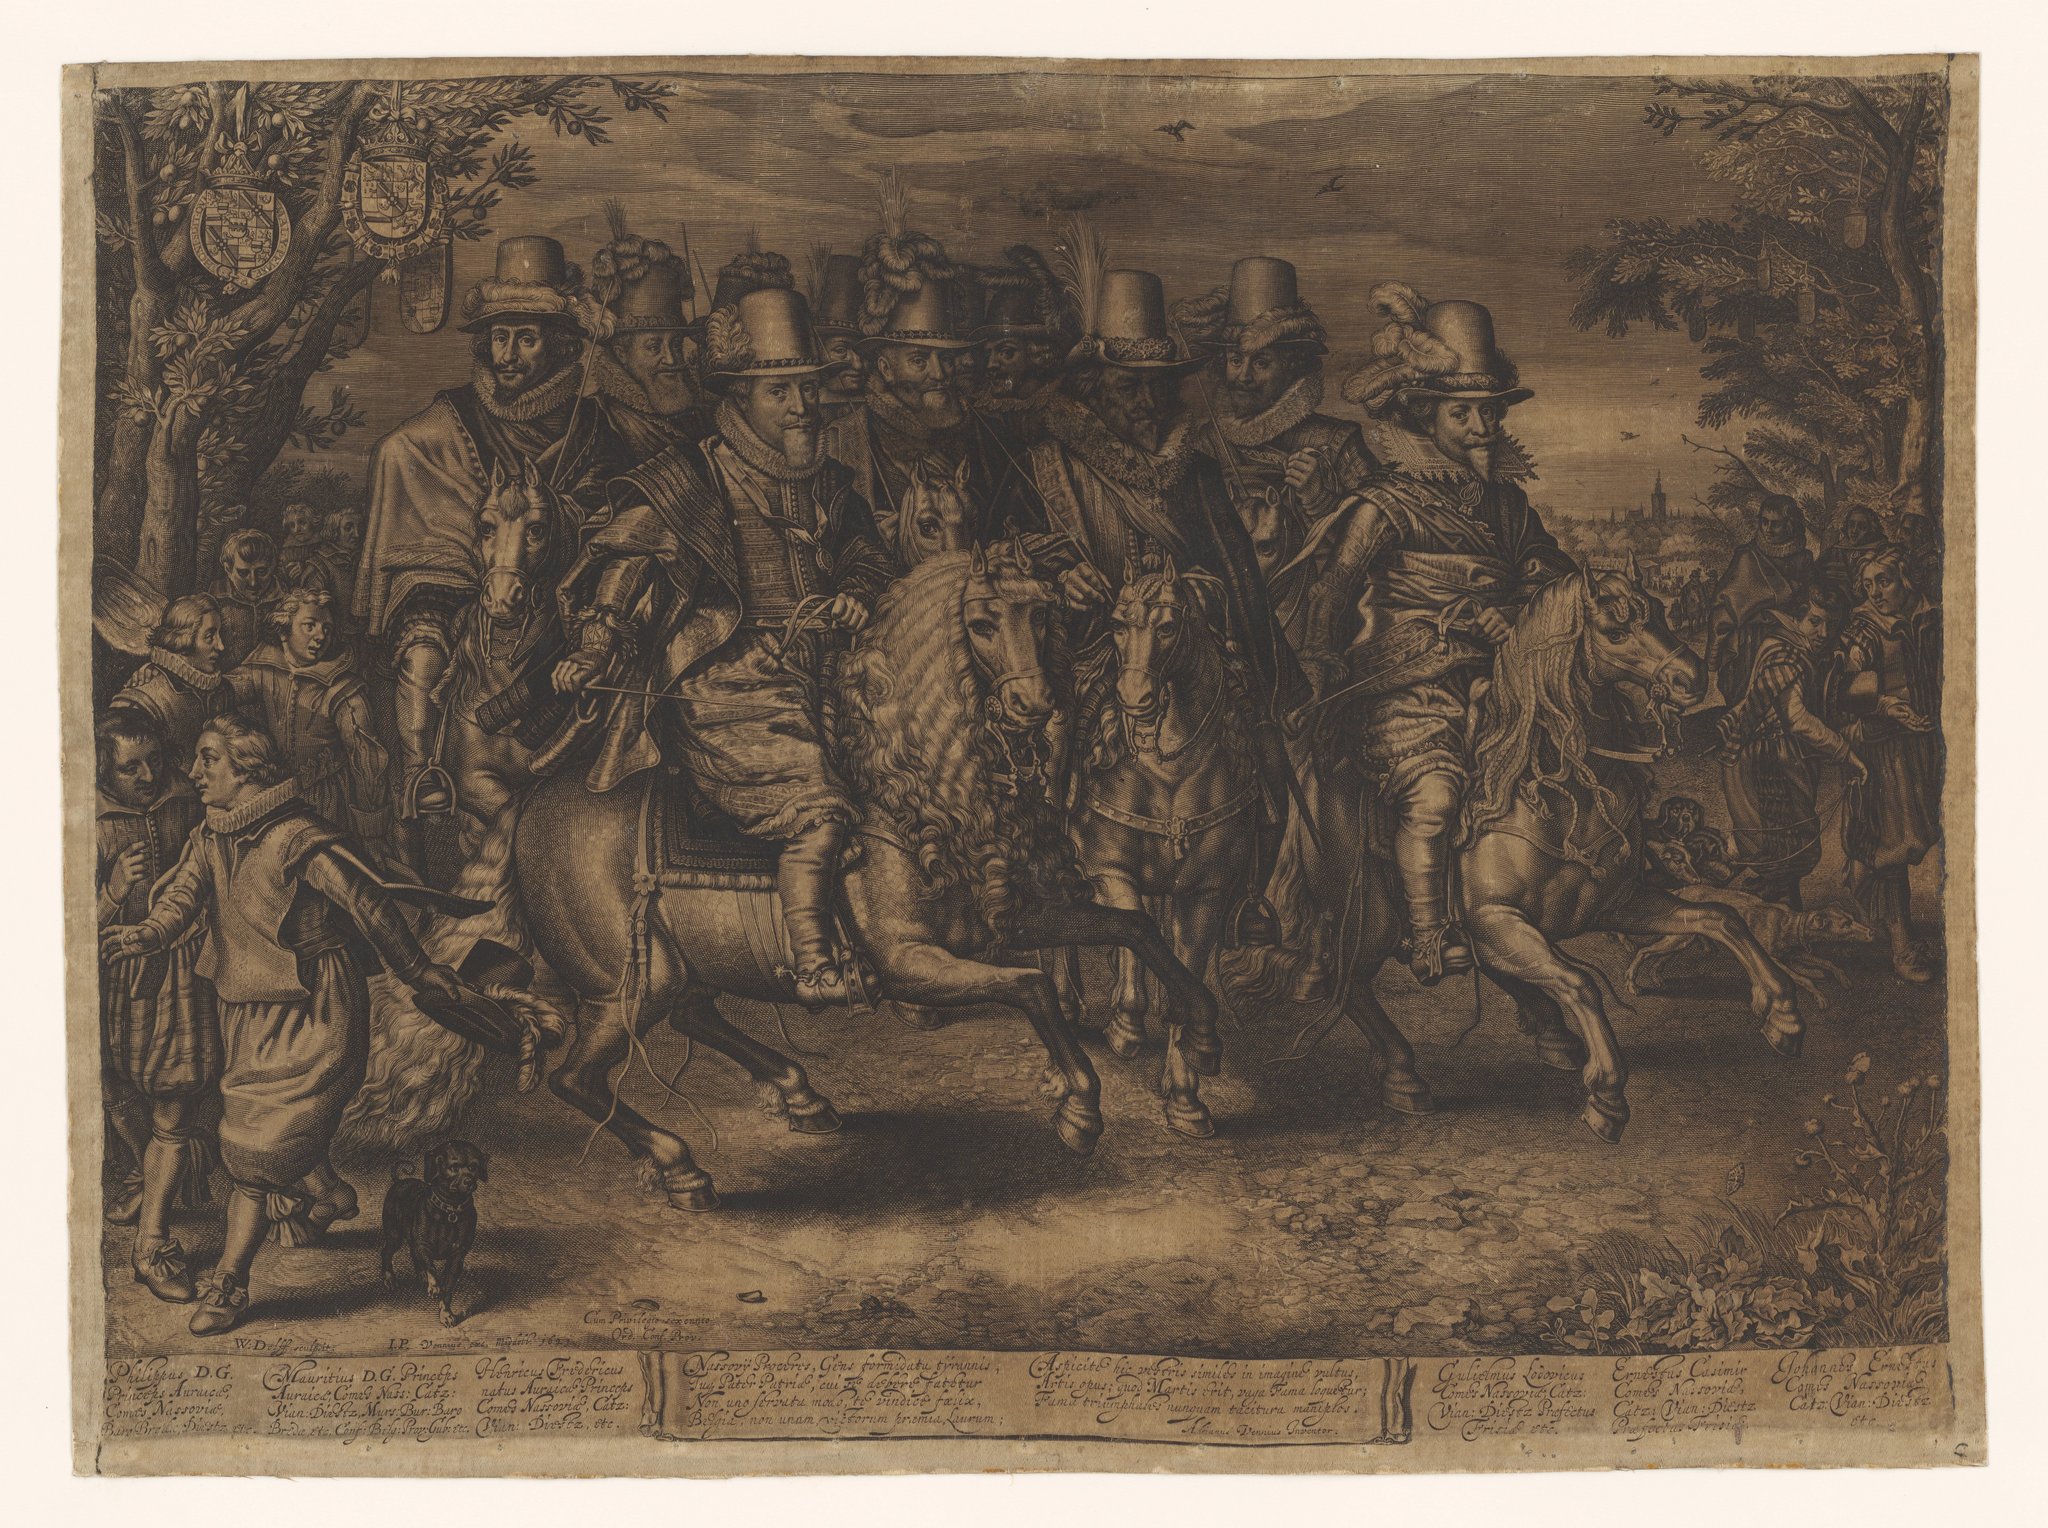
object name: print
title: Ruiterstoet van de zes prinsen van het huis Oranje-Nassau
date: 1621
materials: silk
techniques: engraving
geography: middelburg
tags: delft, the hague, frederick henry (prince of orange), maurice (prince of orange), willem lodewijk graaf van nassau-dillenburg, bruges, filips willem (prins van oranje), ernst casimir graaf van nassau-dietz, johan ernst i graaf van nassau-siegen, equestrian state-portrait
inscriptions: collector's mark: Lugt 240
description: De zes prinsen van het huis Oranje-Nassau in optocht te paard met hun gevolg, van links naar rechts: Maurits, Filips Willem, Frederik Hendrik, Willem Lodewijk, Ernst Casimir en Jan Ernst I. In ondermarge Latijnse namen van de geportretteerden en cartouche met Latijns vers.